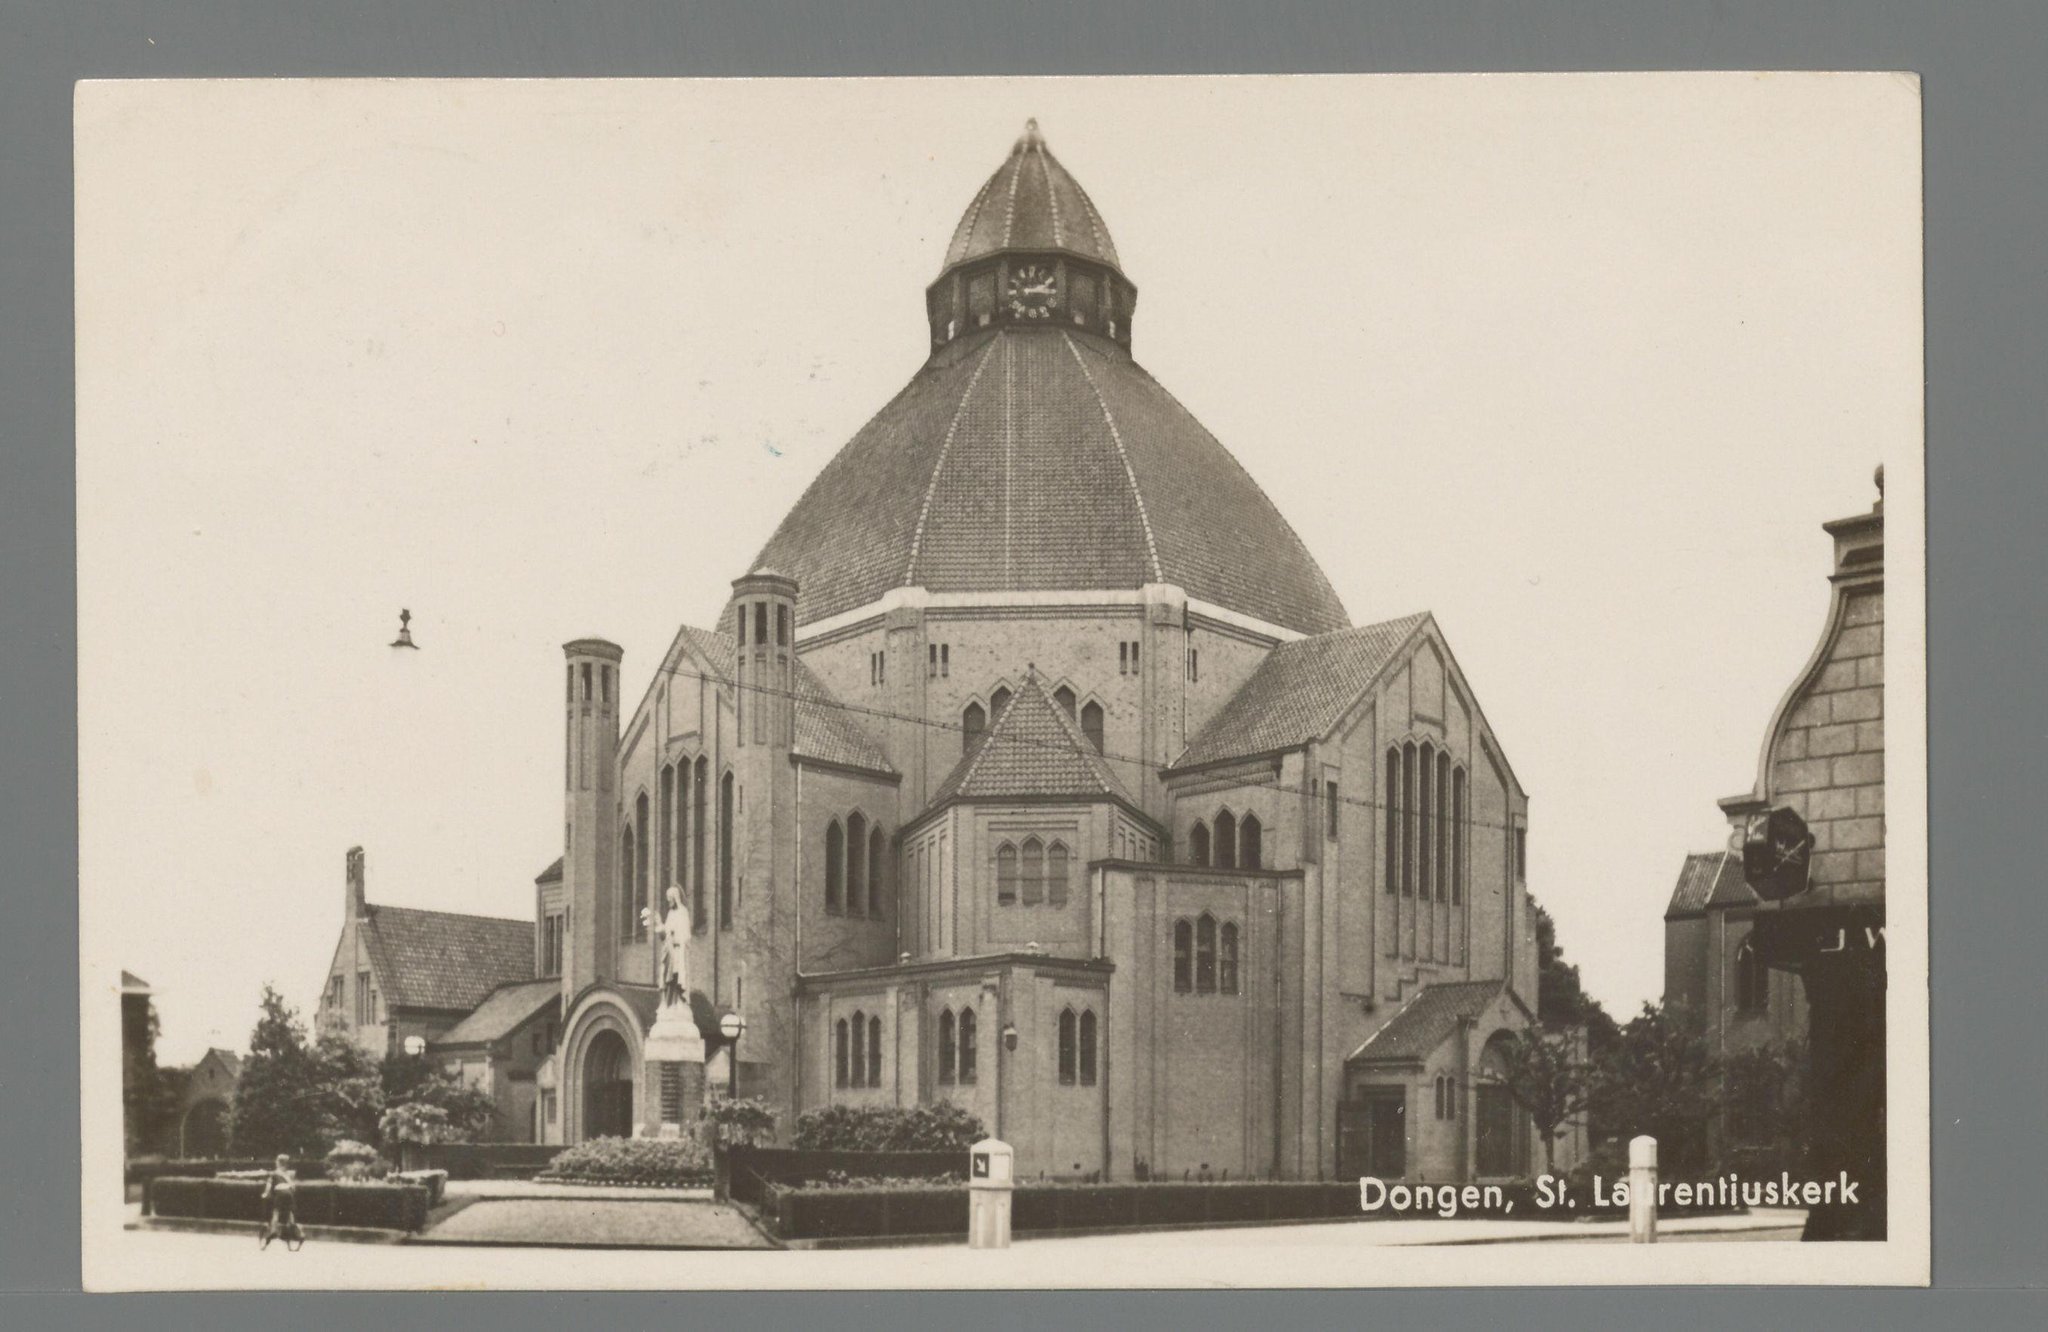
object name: photograph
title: Dongen, St. Laurentiuskerk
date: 1929-1941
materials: paper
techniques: gelatin silver print, writing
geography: dongen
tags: church (exterior)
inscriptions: postage stamp